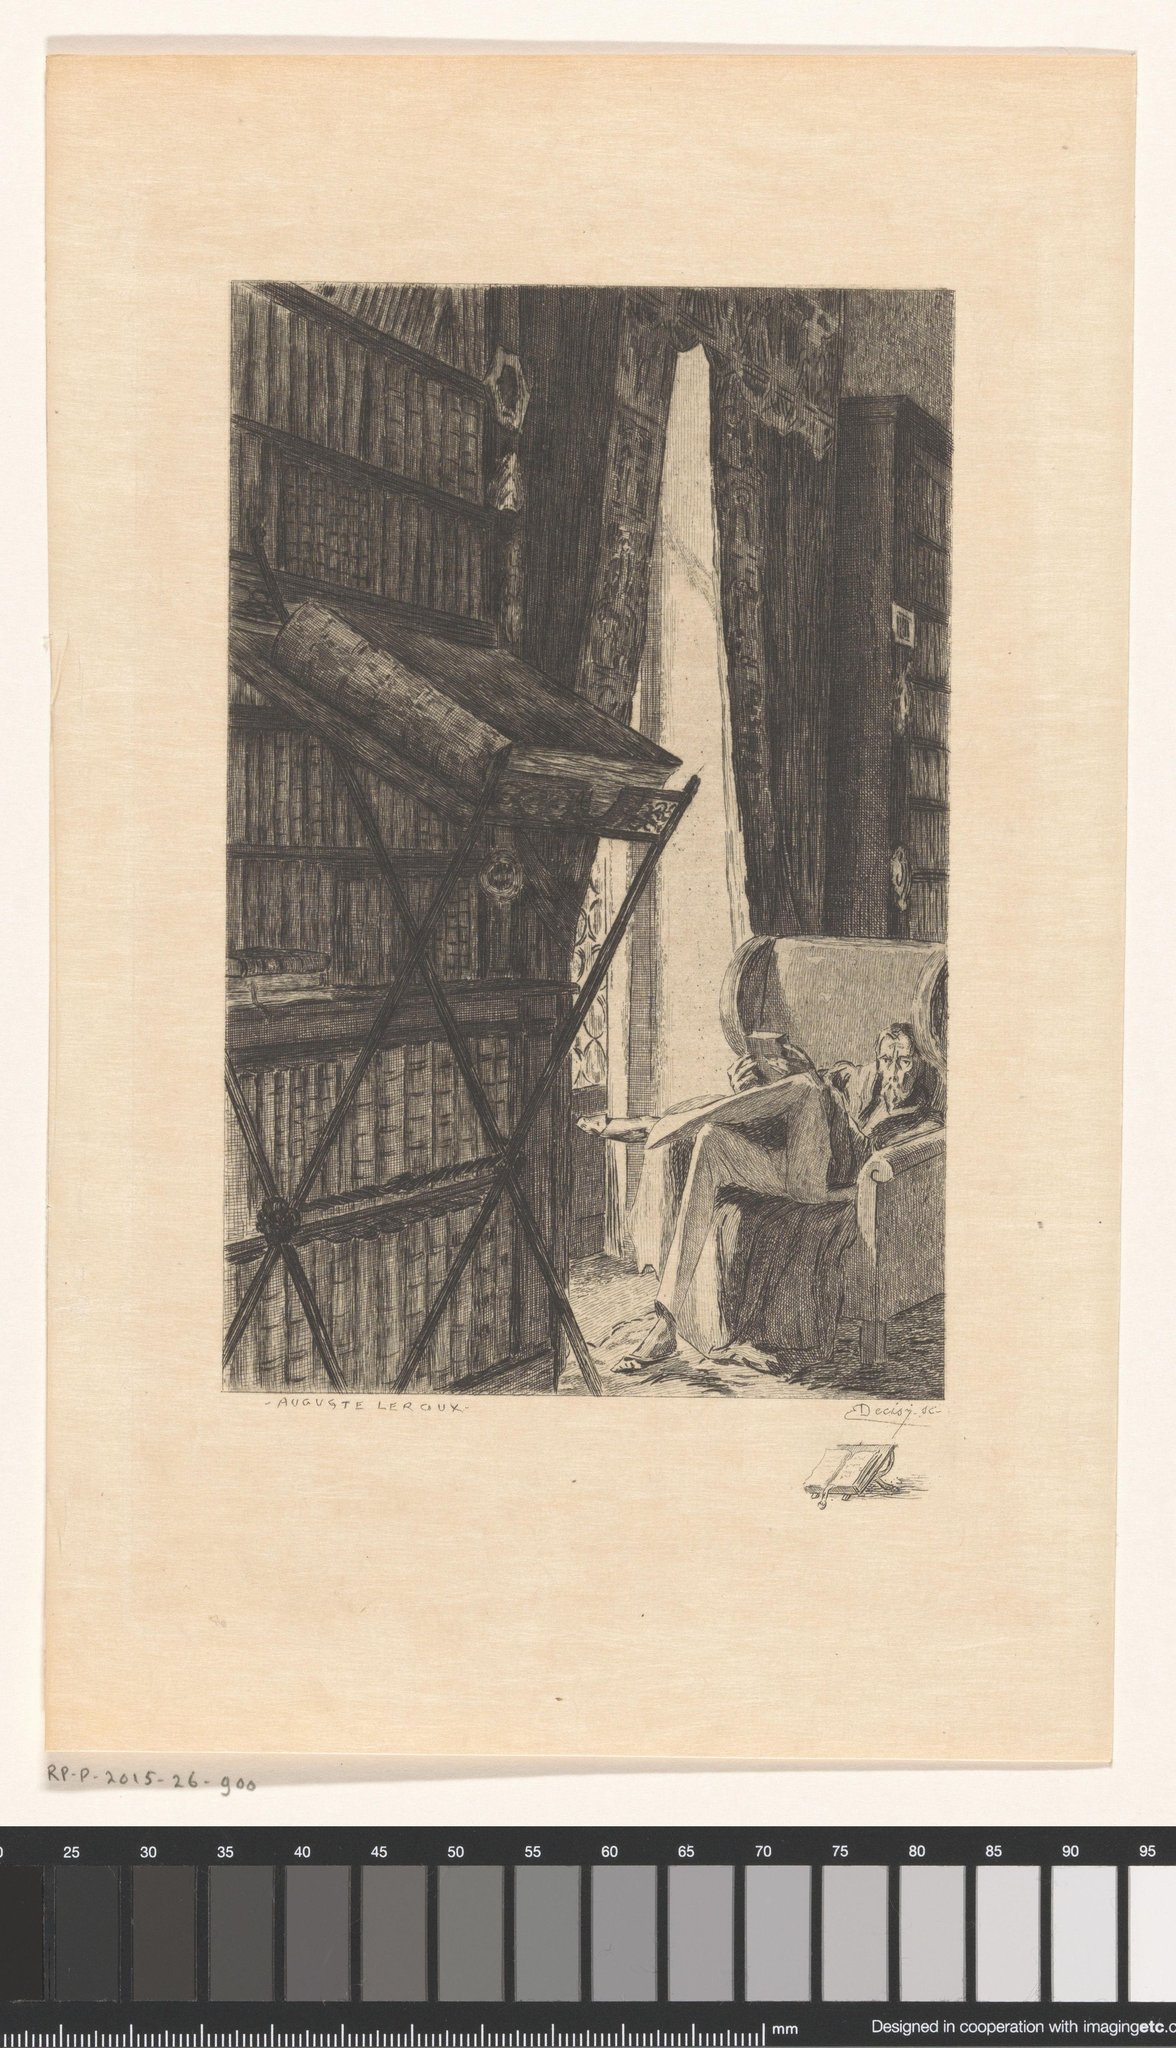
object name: print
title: Man in een stoel in een bibliotheek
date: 1881-1936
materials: paper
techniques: drypoint, etching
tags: bookshelves, study; 'studiolo'; library, lectern ~ reading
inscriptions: collector's mark: Lugt 4780, collector's mark: Lugt 2228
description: Een man zit met een boek in zijn handen diep weggezakt in een luie stoel voor het raam. Aan weerszijden van het raam boekenkasten, een lessenaar met een boek op de voorgrond.